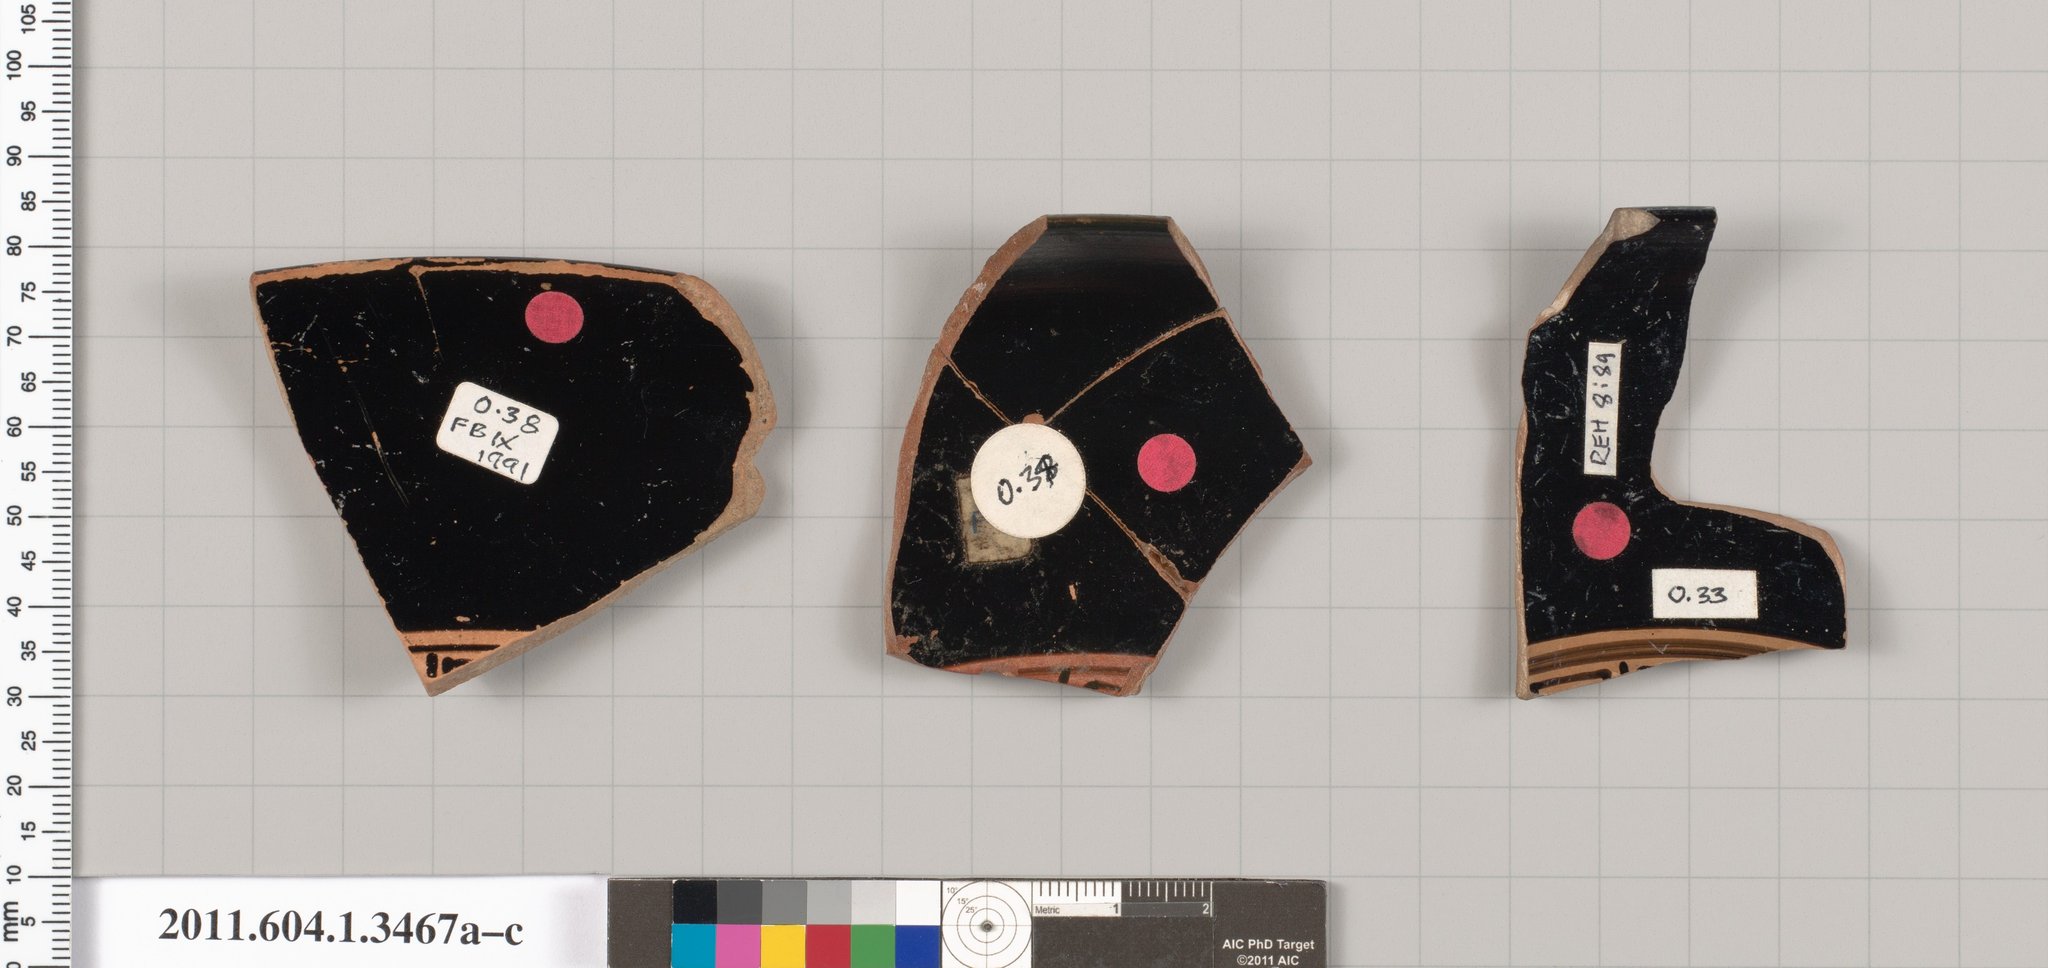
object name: kylix fragment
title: Terracotta rim fragments of kylikes (drinking cups)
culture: greek, attic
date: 500-470 BCE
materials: terracotta